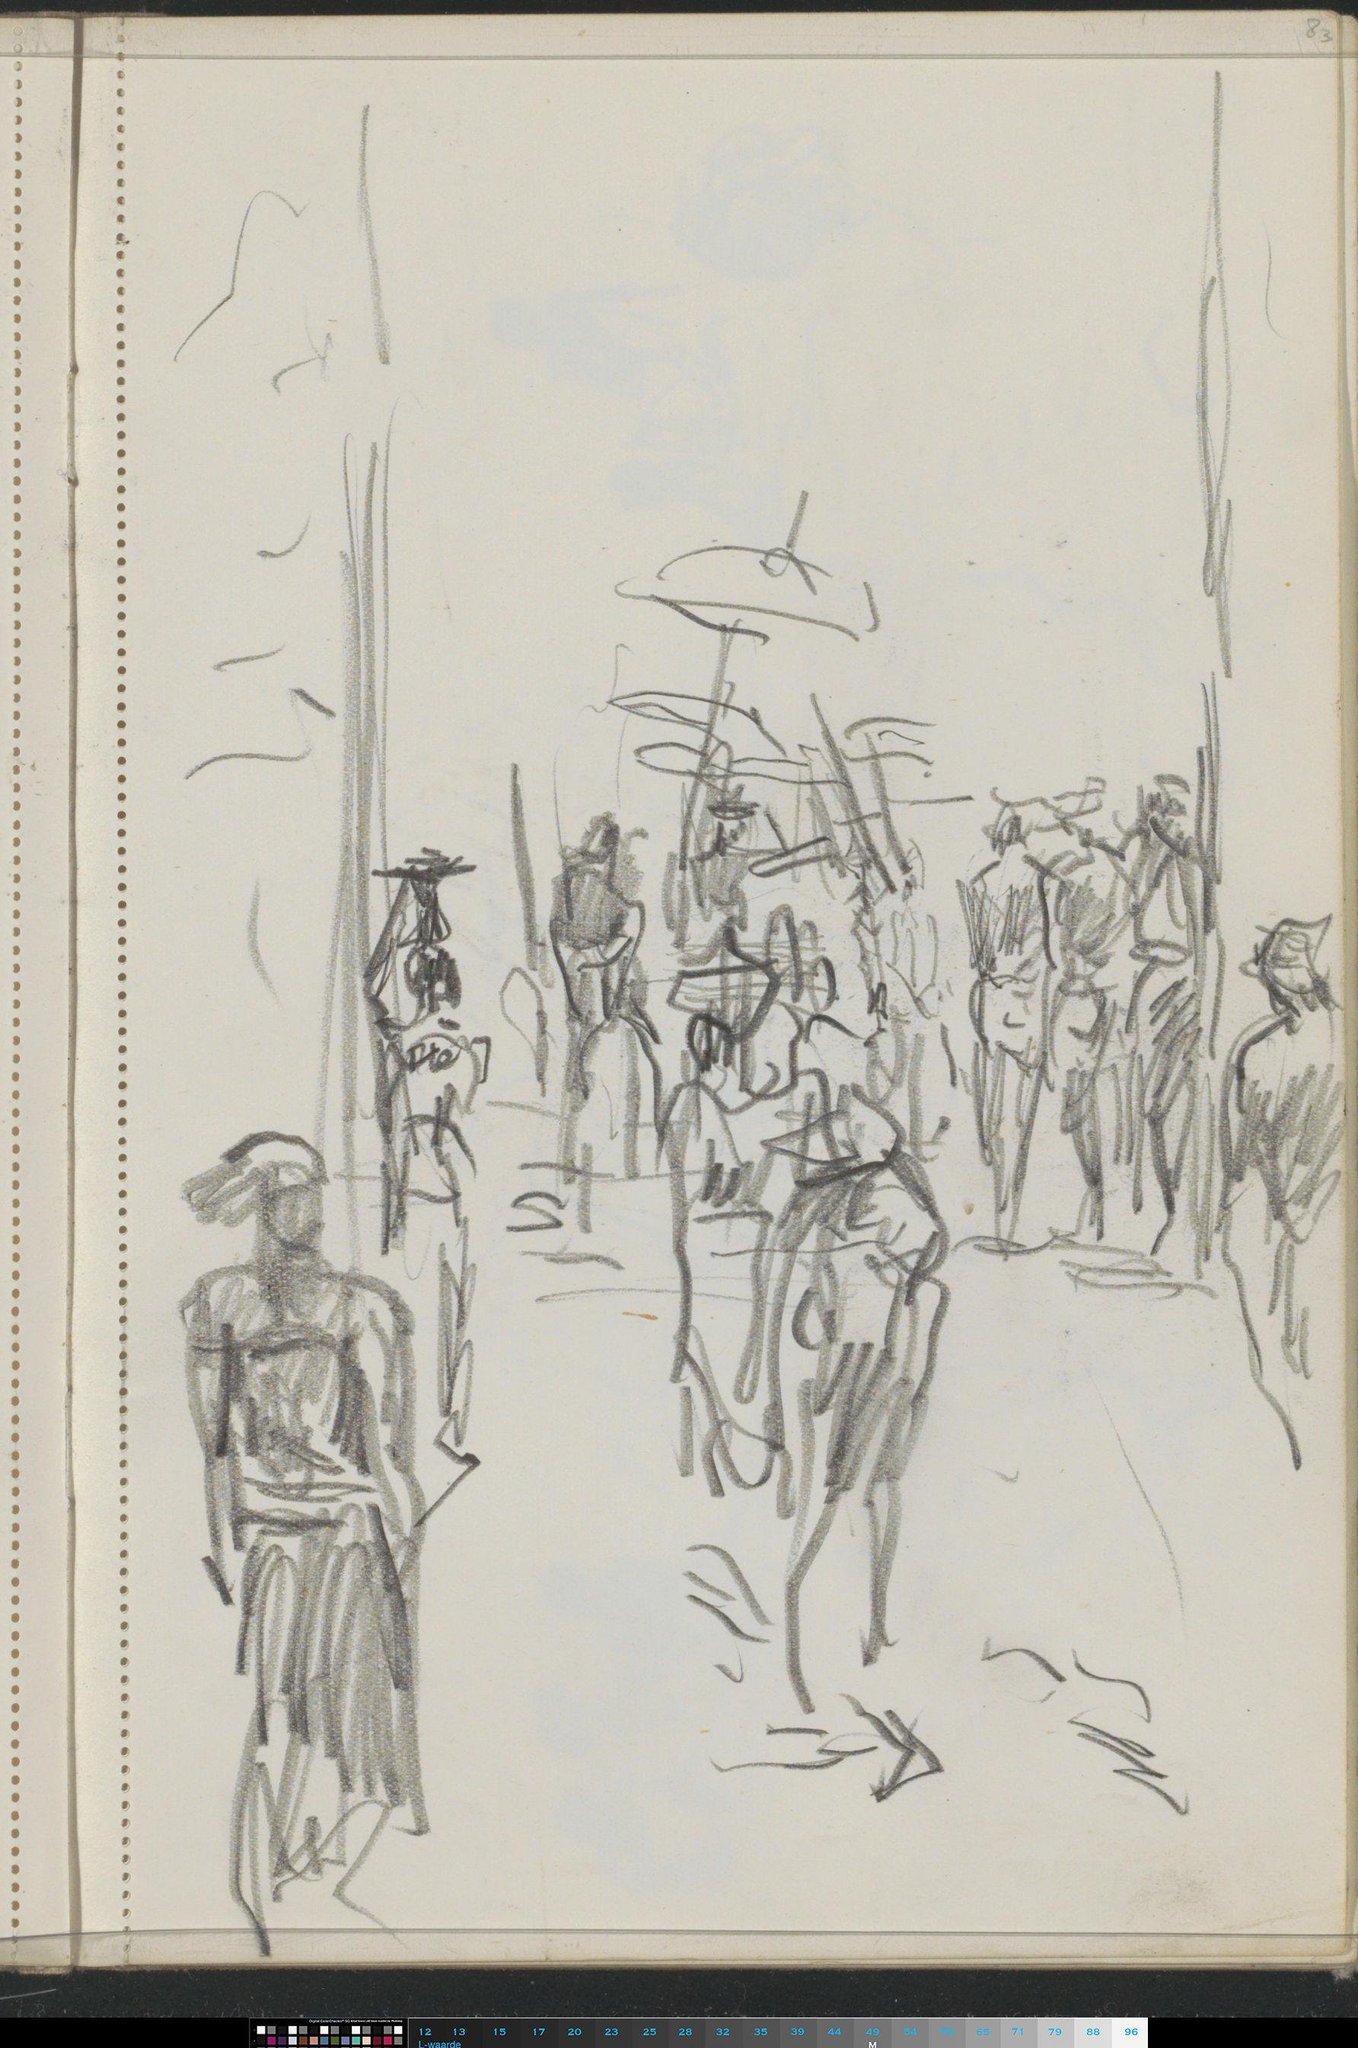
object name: sketchbook leaf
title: Optocht van figuren met parasols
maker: marius bauer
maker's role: draughtsman, print maker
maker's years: 1867-1932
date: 1925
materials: paper, pencil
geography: indonesia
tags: asiatic races and peoples, walking, parasol, sunshade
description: Pagina 83 uit een schetsboek met 74 bladen.